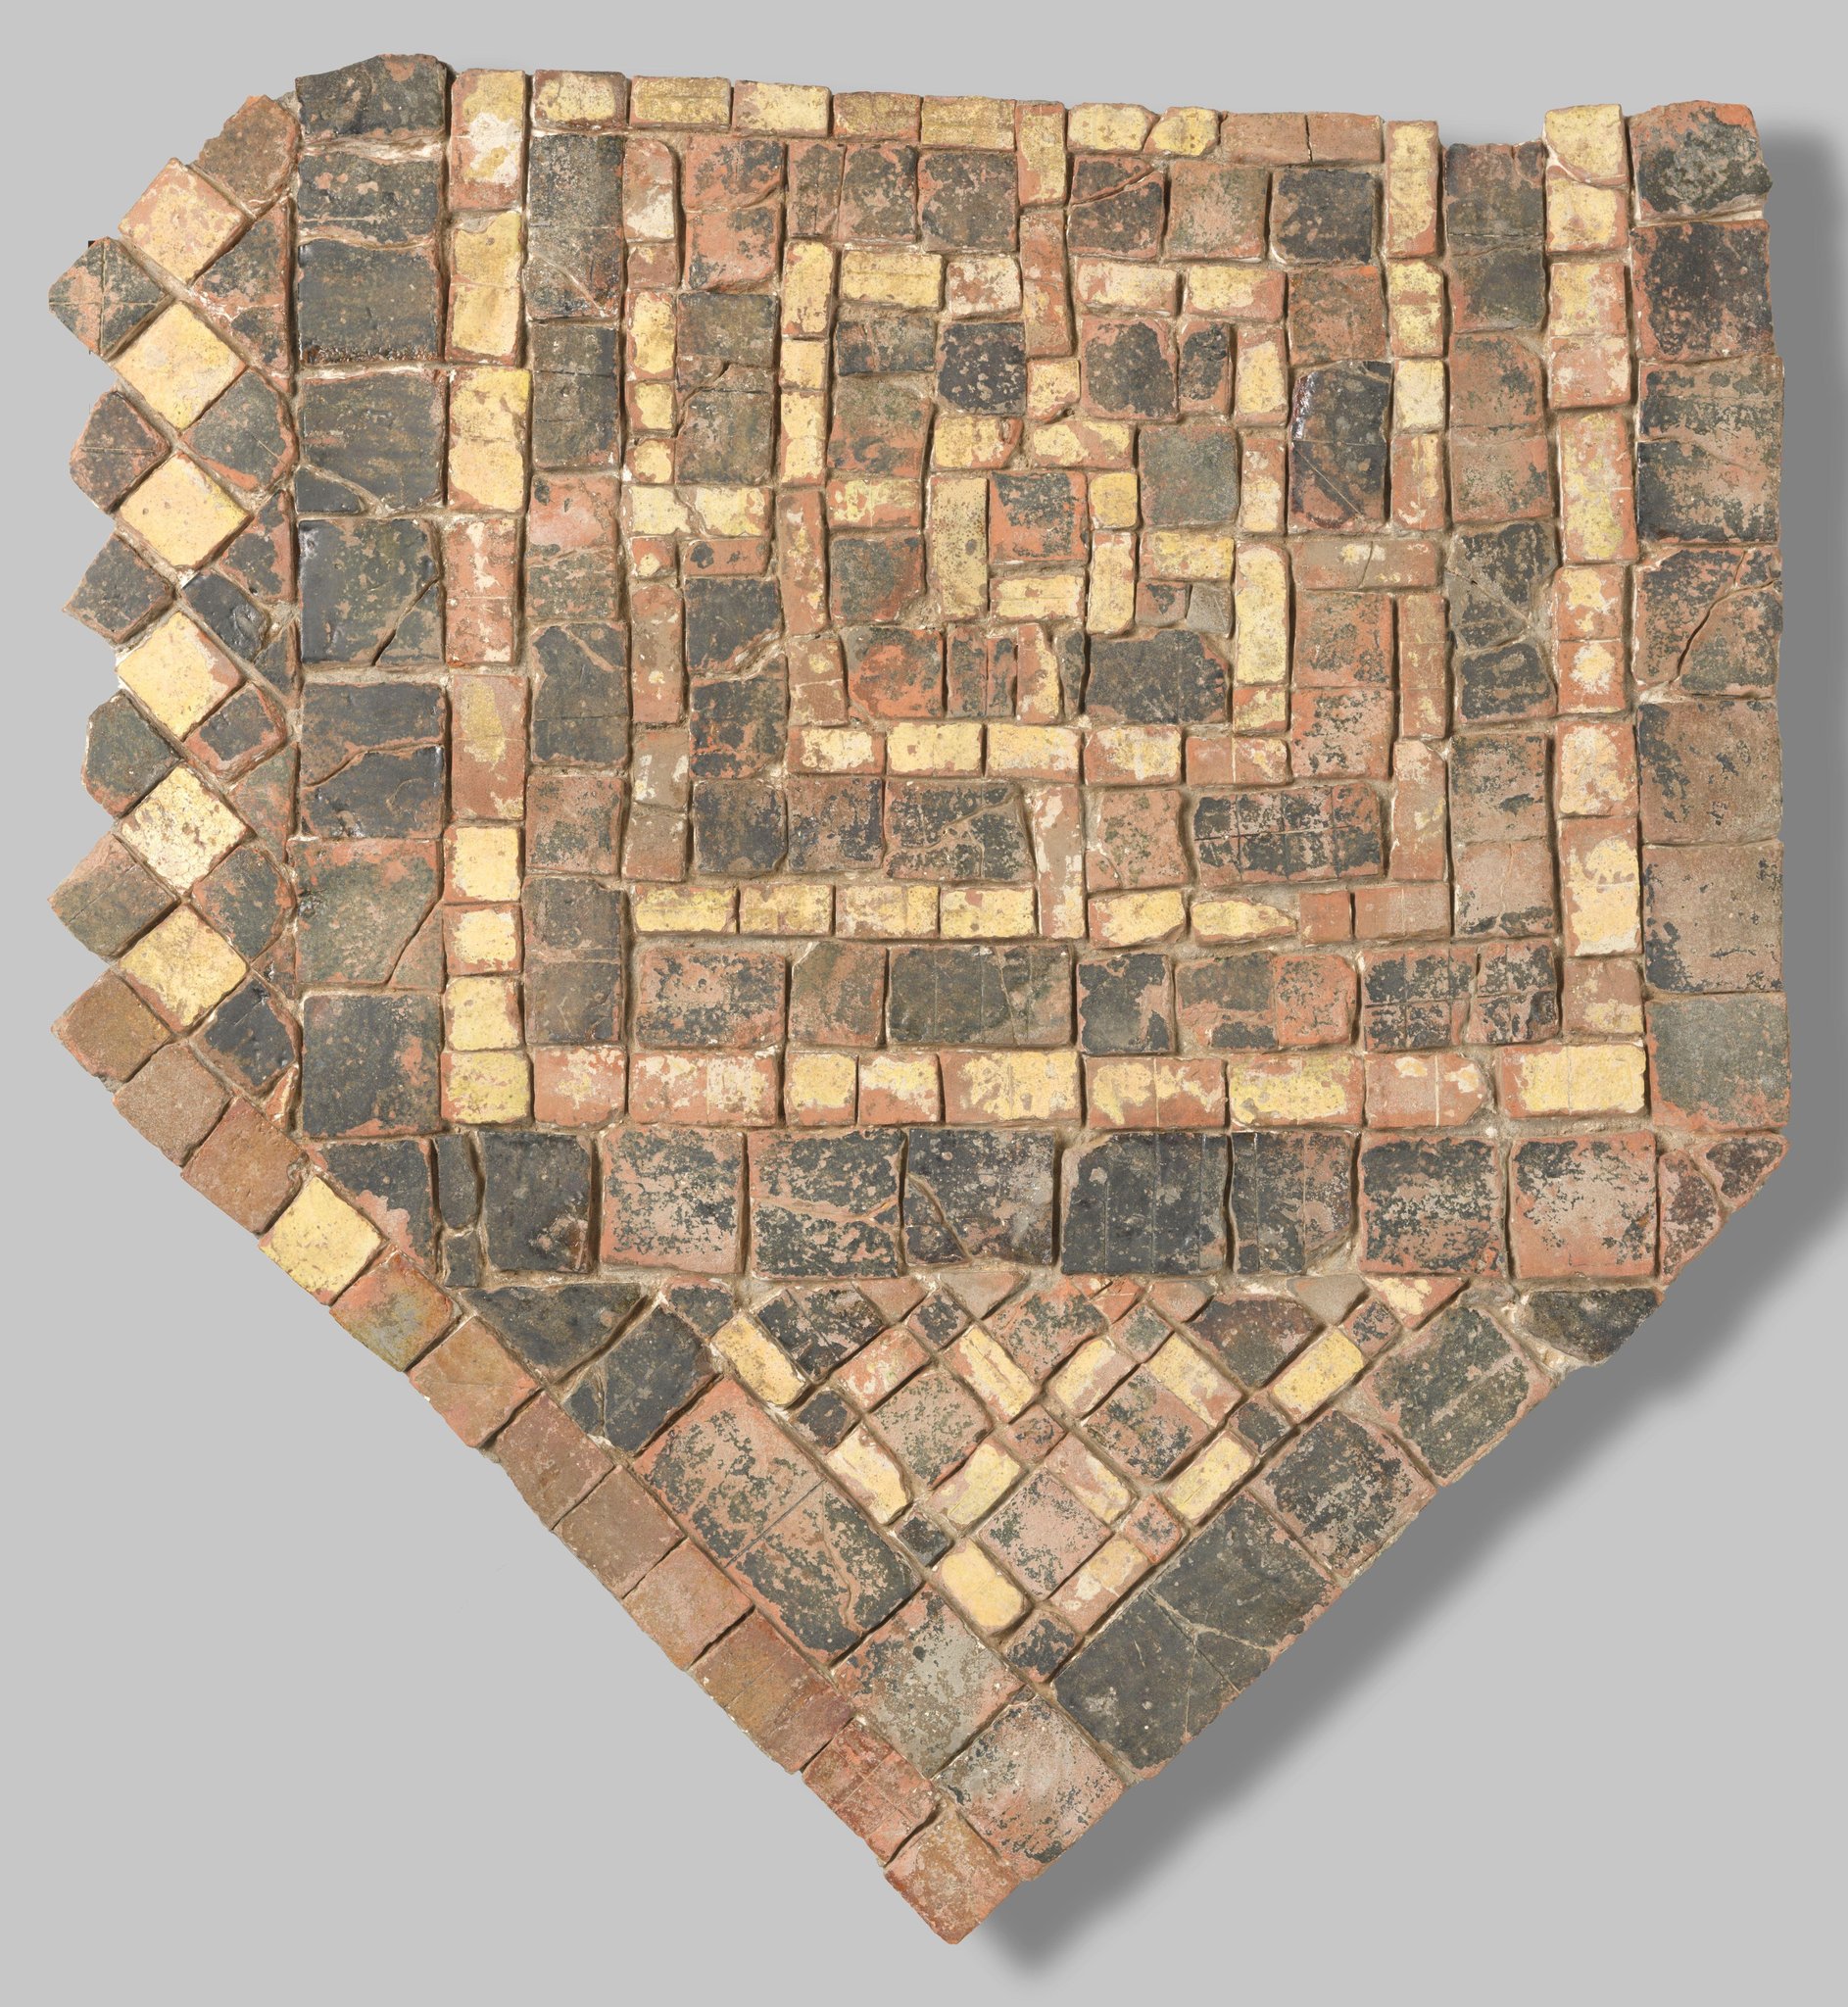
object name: floor tile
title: Deel van tegelvloer afkomstig uit de Nederlands Hervormde Kerk te Heukelum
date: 1325-1375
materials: ceramic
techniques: vitrification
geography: utrecht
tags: heukelum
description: Vijfhoekig deel van vloer bestaand uit geglazuurde tegels in de kleuren zwart, groen, rood en geel. De tegels zijn geplakt op een dikke plaat.